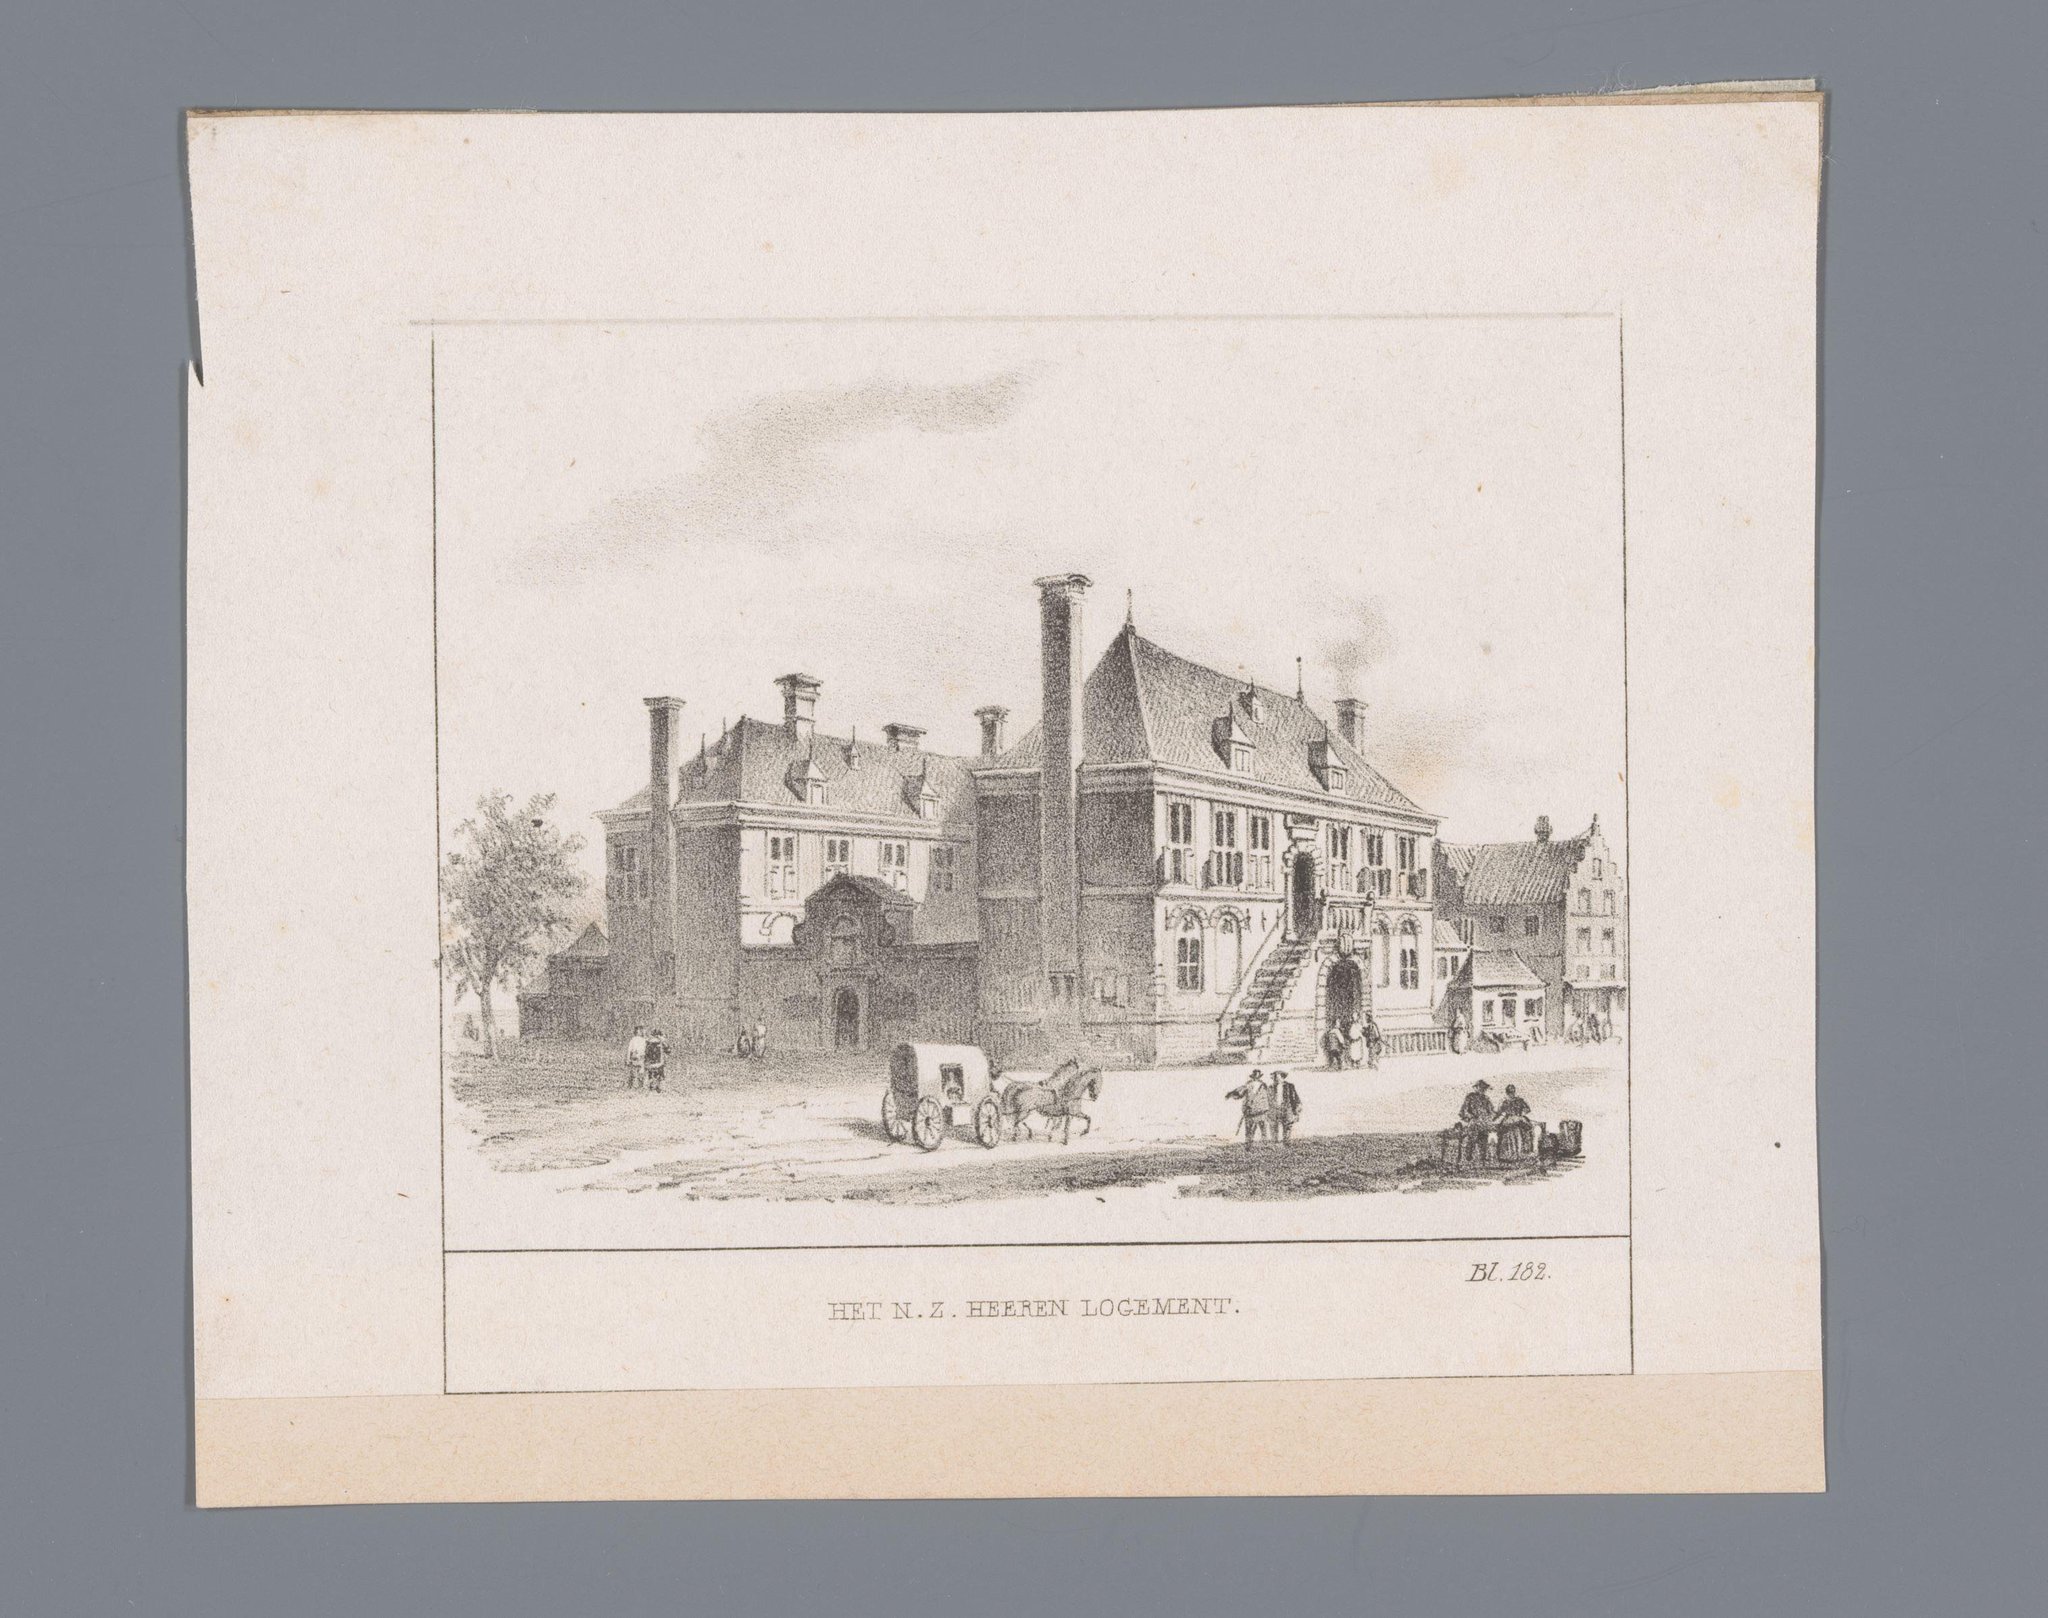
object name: print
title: Gezicht op het Nieuwezijds Heerenlogement in Amsterdam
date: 1844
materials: paper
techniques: lithograph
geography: amsterdam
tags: animal traction, animal-drawn vehicle (carriage etc.), hotel, hostelry, inn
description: Prent uit: Vijver, Cornelius van der. Geschiedkundige beschrijving der stad Amsterdam (...). 4 dln. Amsterdam: Gebroeders Diederichs, 1844-1848, dl. 1 (1844), p. 182-183.